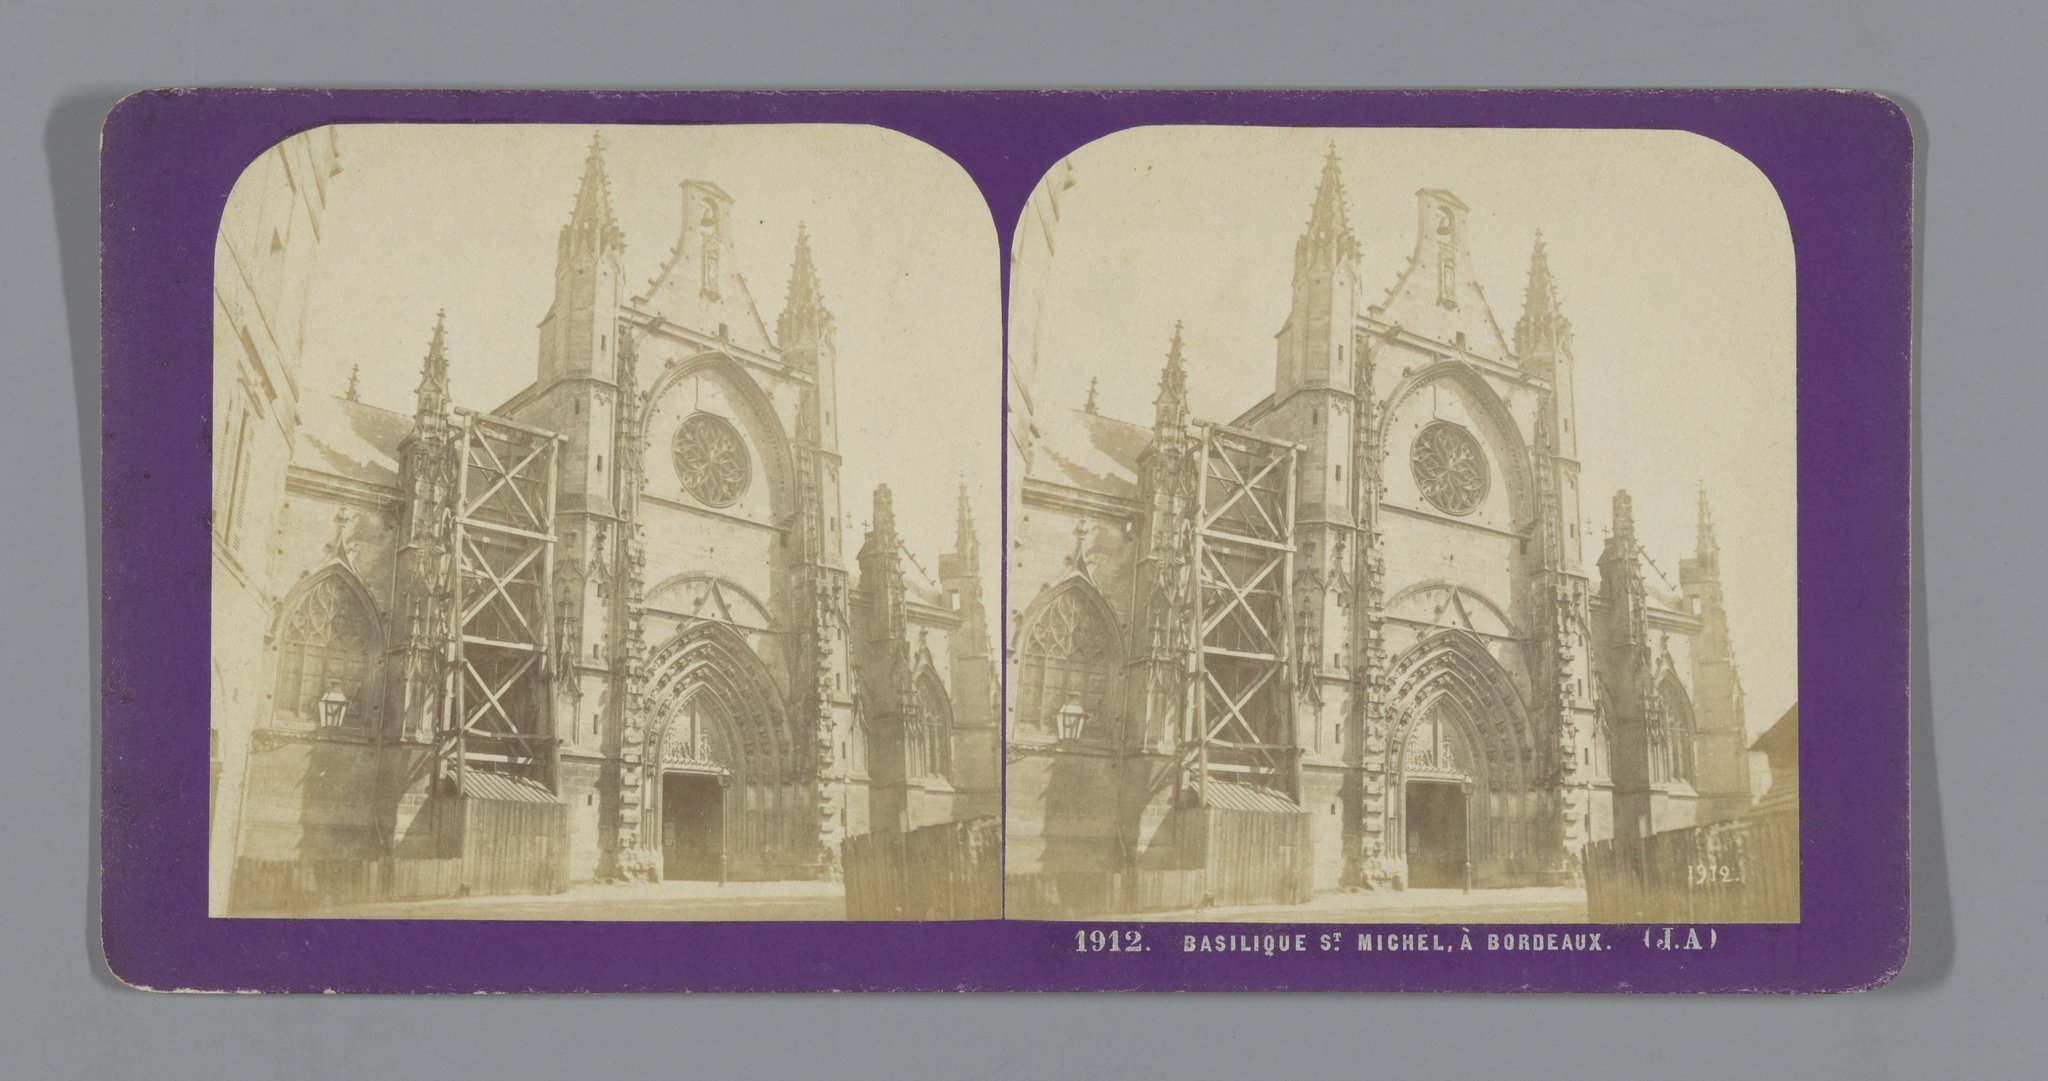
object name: stereograph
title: Basilique St. Michel, à Bordeaux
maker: jean andrieu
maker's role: fotograaf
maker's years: 1816-1872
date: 1862-1876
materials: cardboard, photographic support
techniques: albumen print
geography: bordeaux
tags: church (exterior), façade (of house or building)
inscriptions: number: ‘1912.’